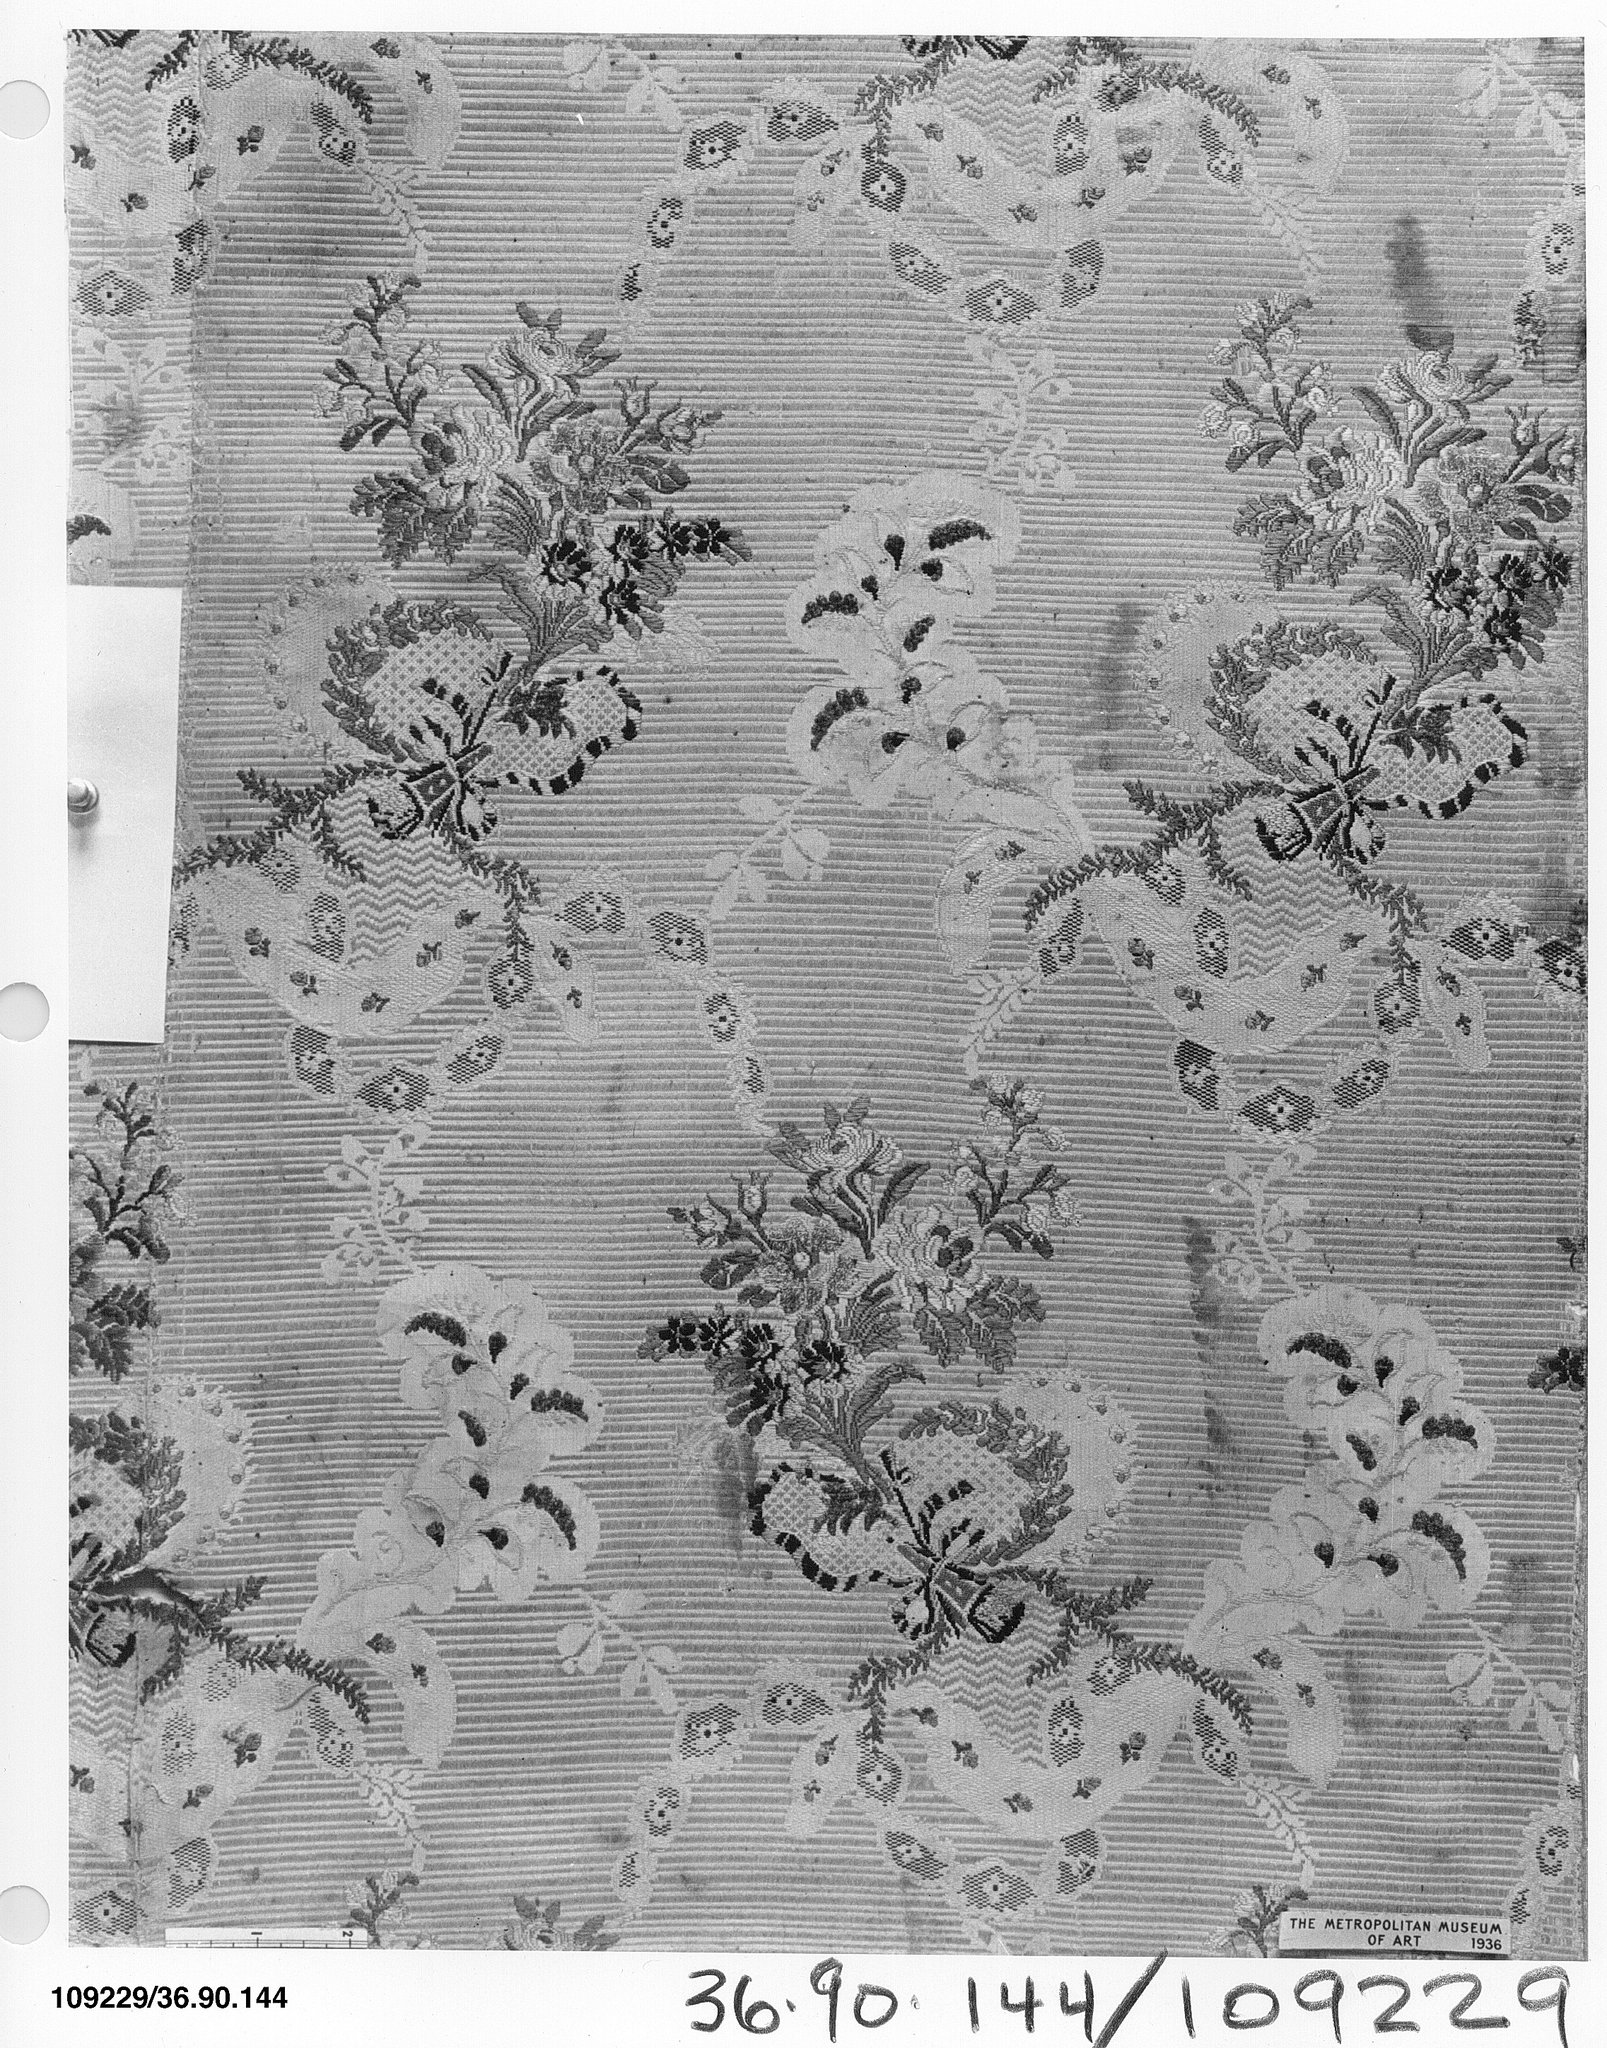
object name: piece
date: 1760-1770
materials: silk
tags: flowers